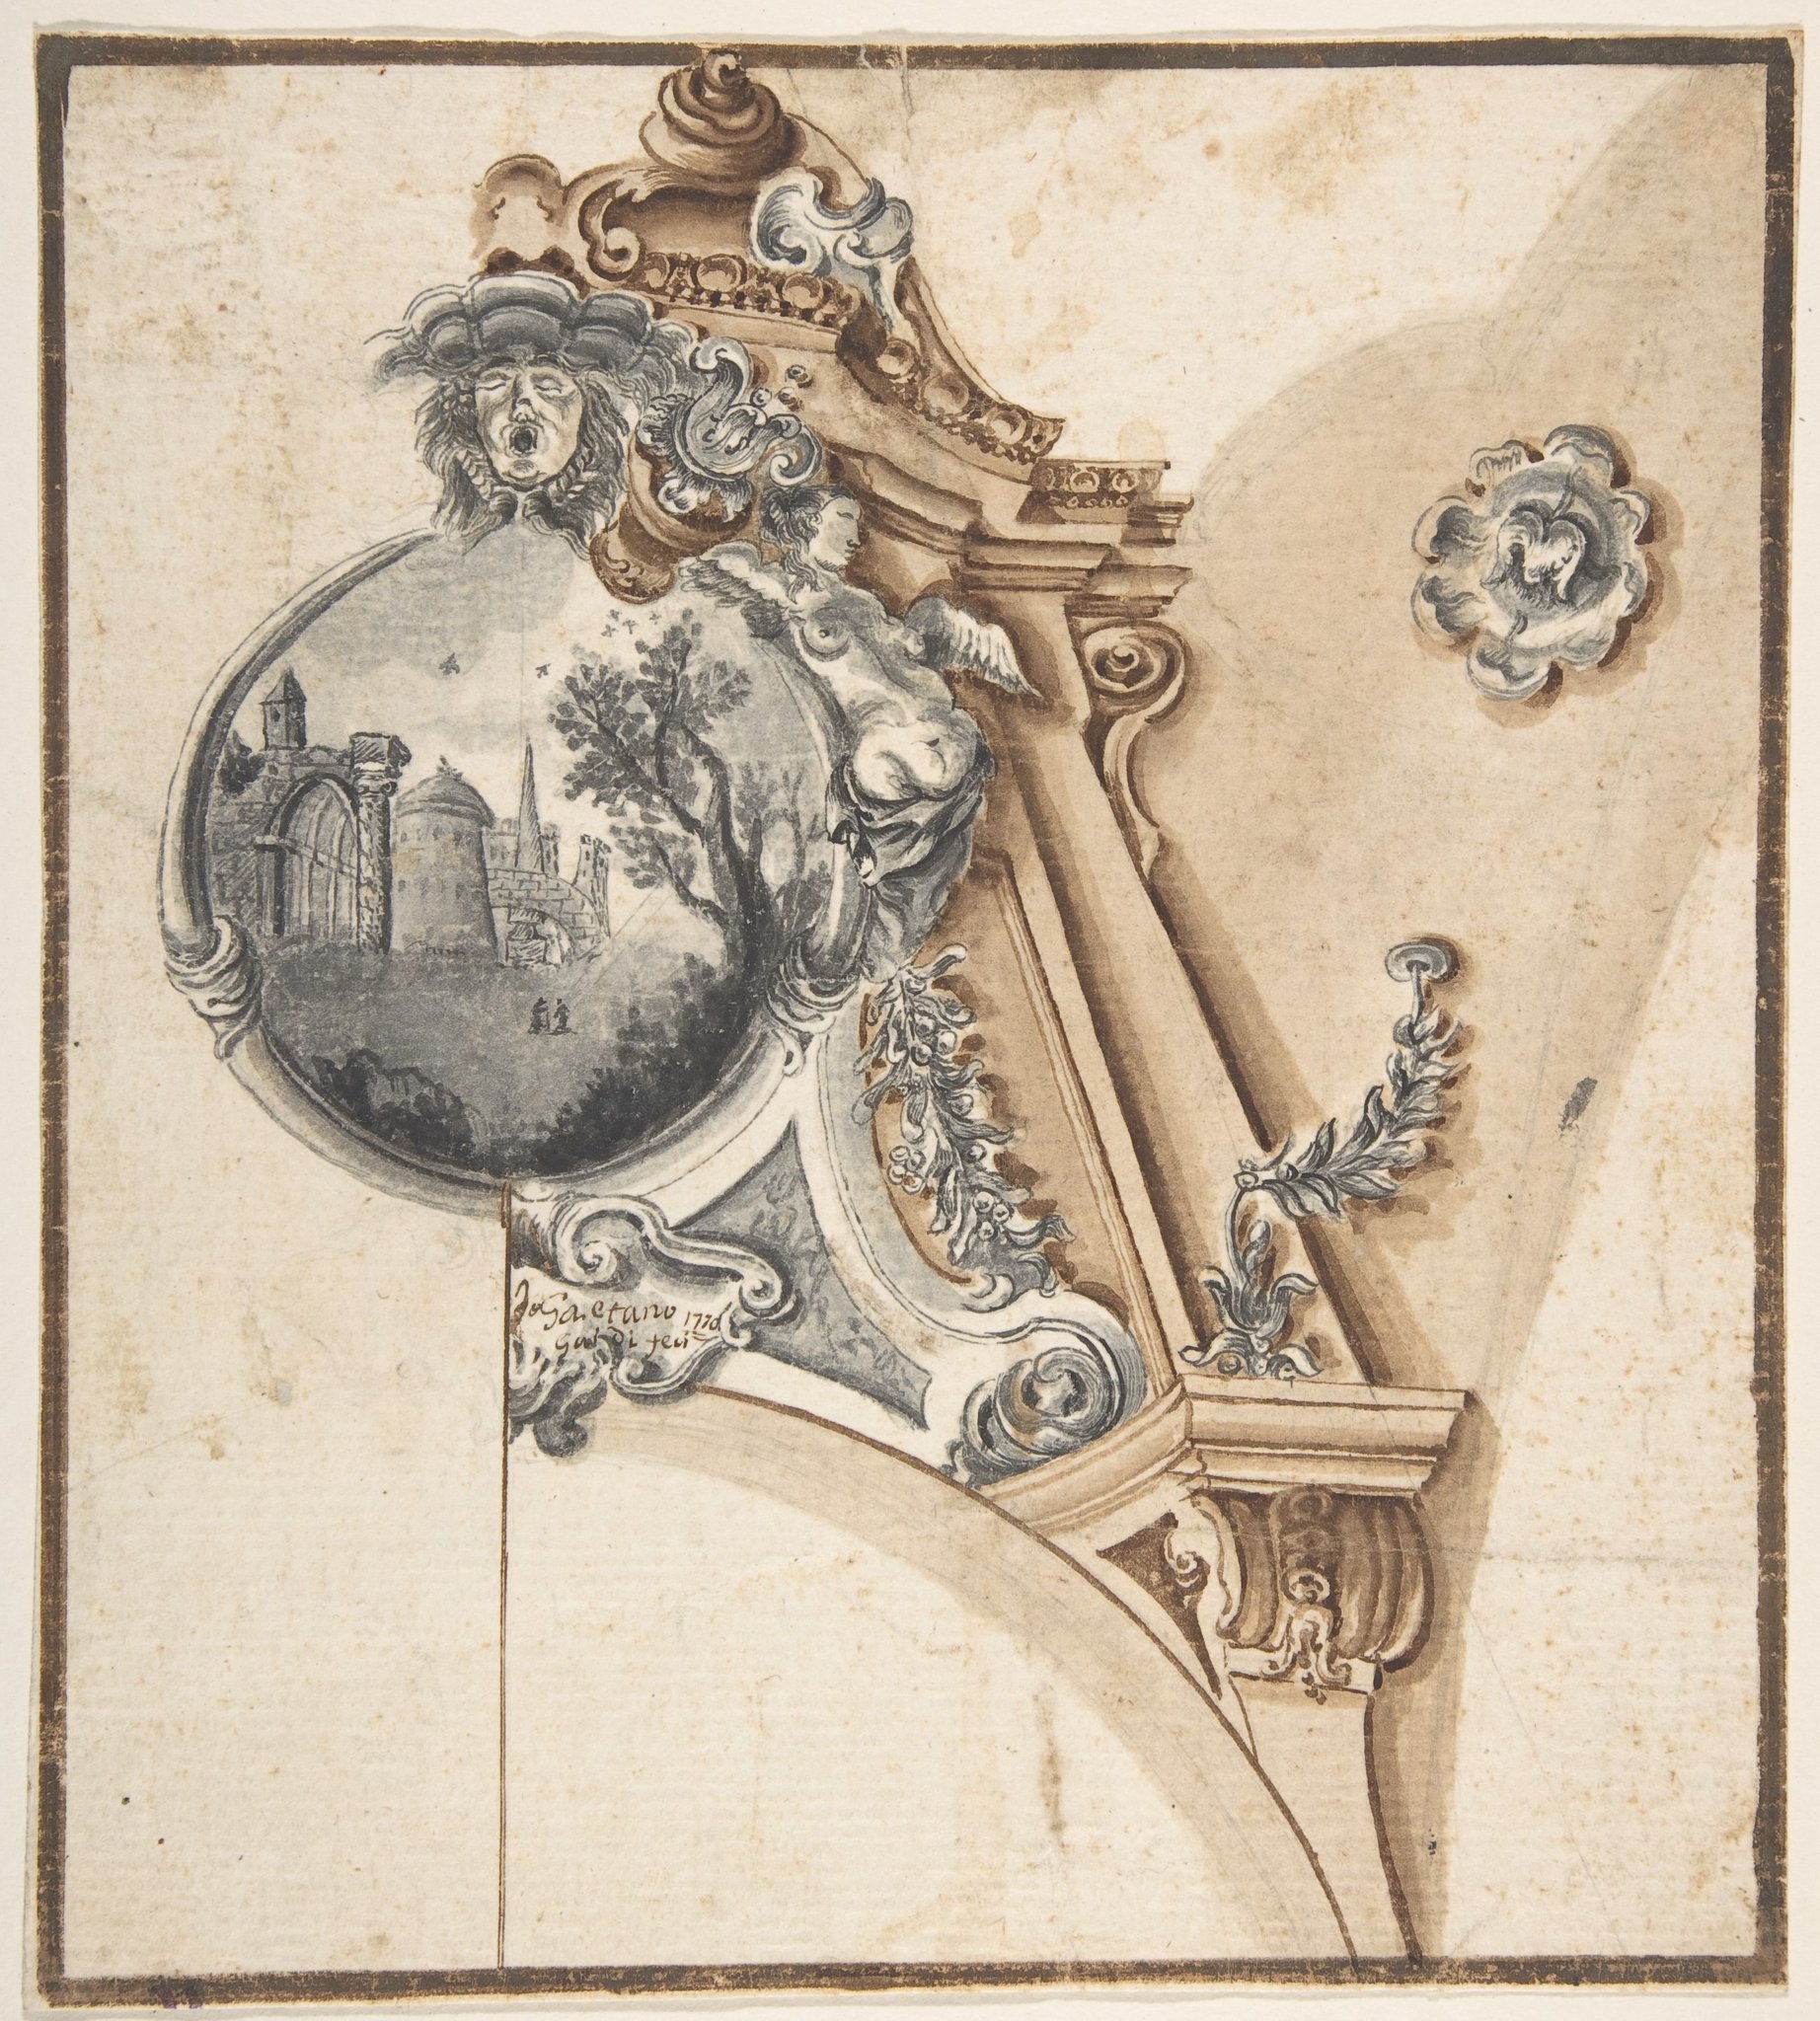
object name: drawing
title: Decoration over an Arch with a Landscape Scene in a Round Compartment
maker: gaetano galdi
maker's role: artist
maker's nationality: italian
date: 1770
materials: graphite, ink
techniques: brush, pen, wash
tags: faces,landscapes